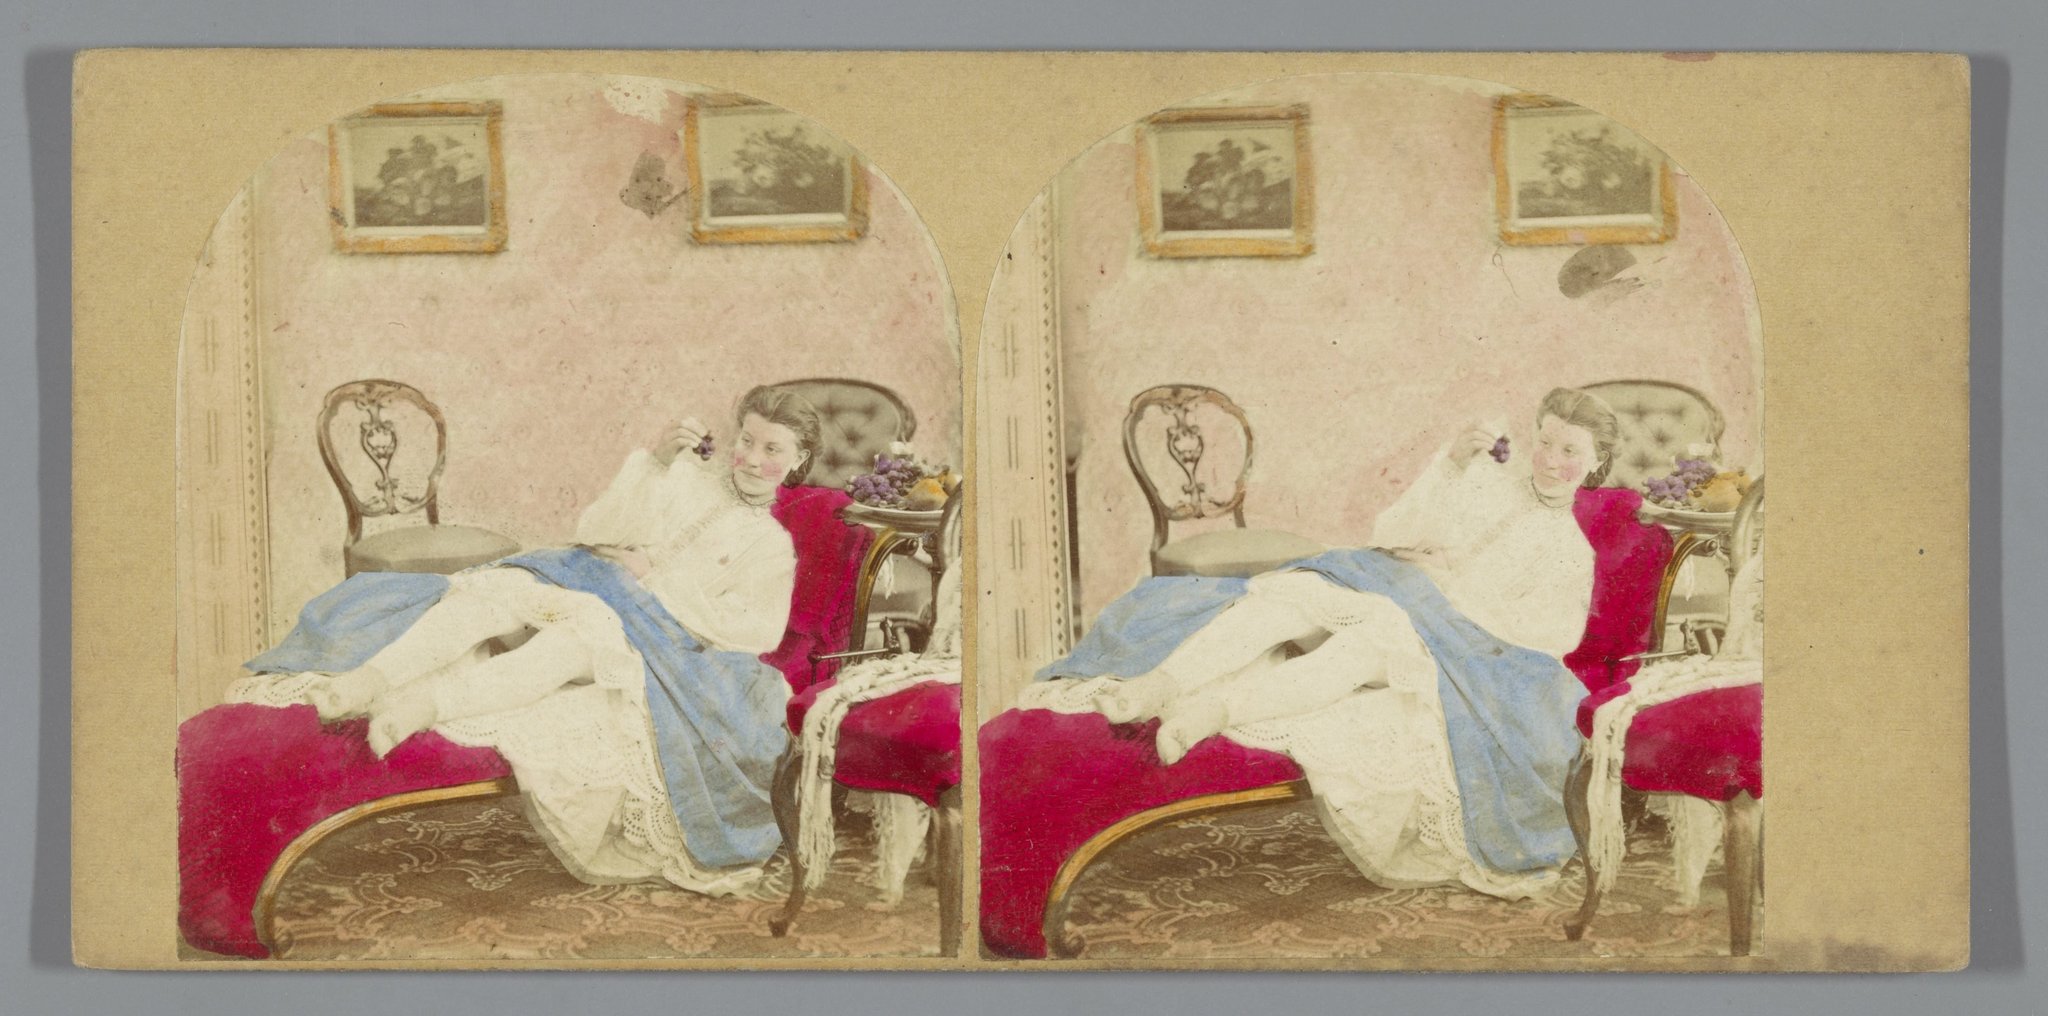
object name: stereograph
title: Repose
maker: Anonymous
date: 1852-1863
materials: cardboard, paper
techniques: albumen print, hand coloring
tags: adult woman, living-room, parlour, sitting-room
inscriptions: copyright notice: ‘Copyright.’